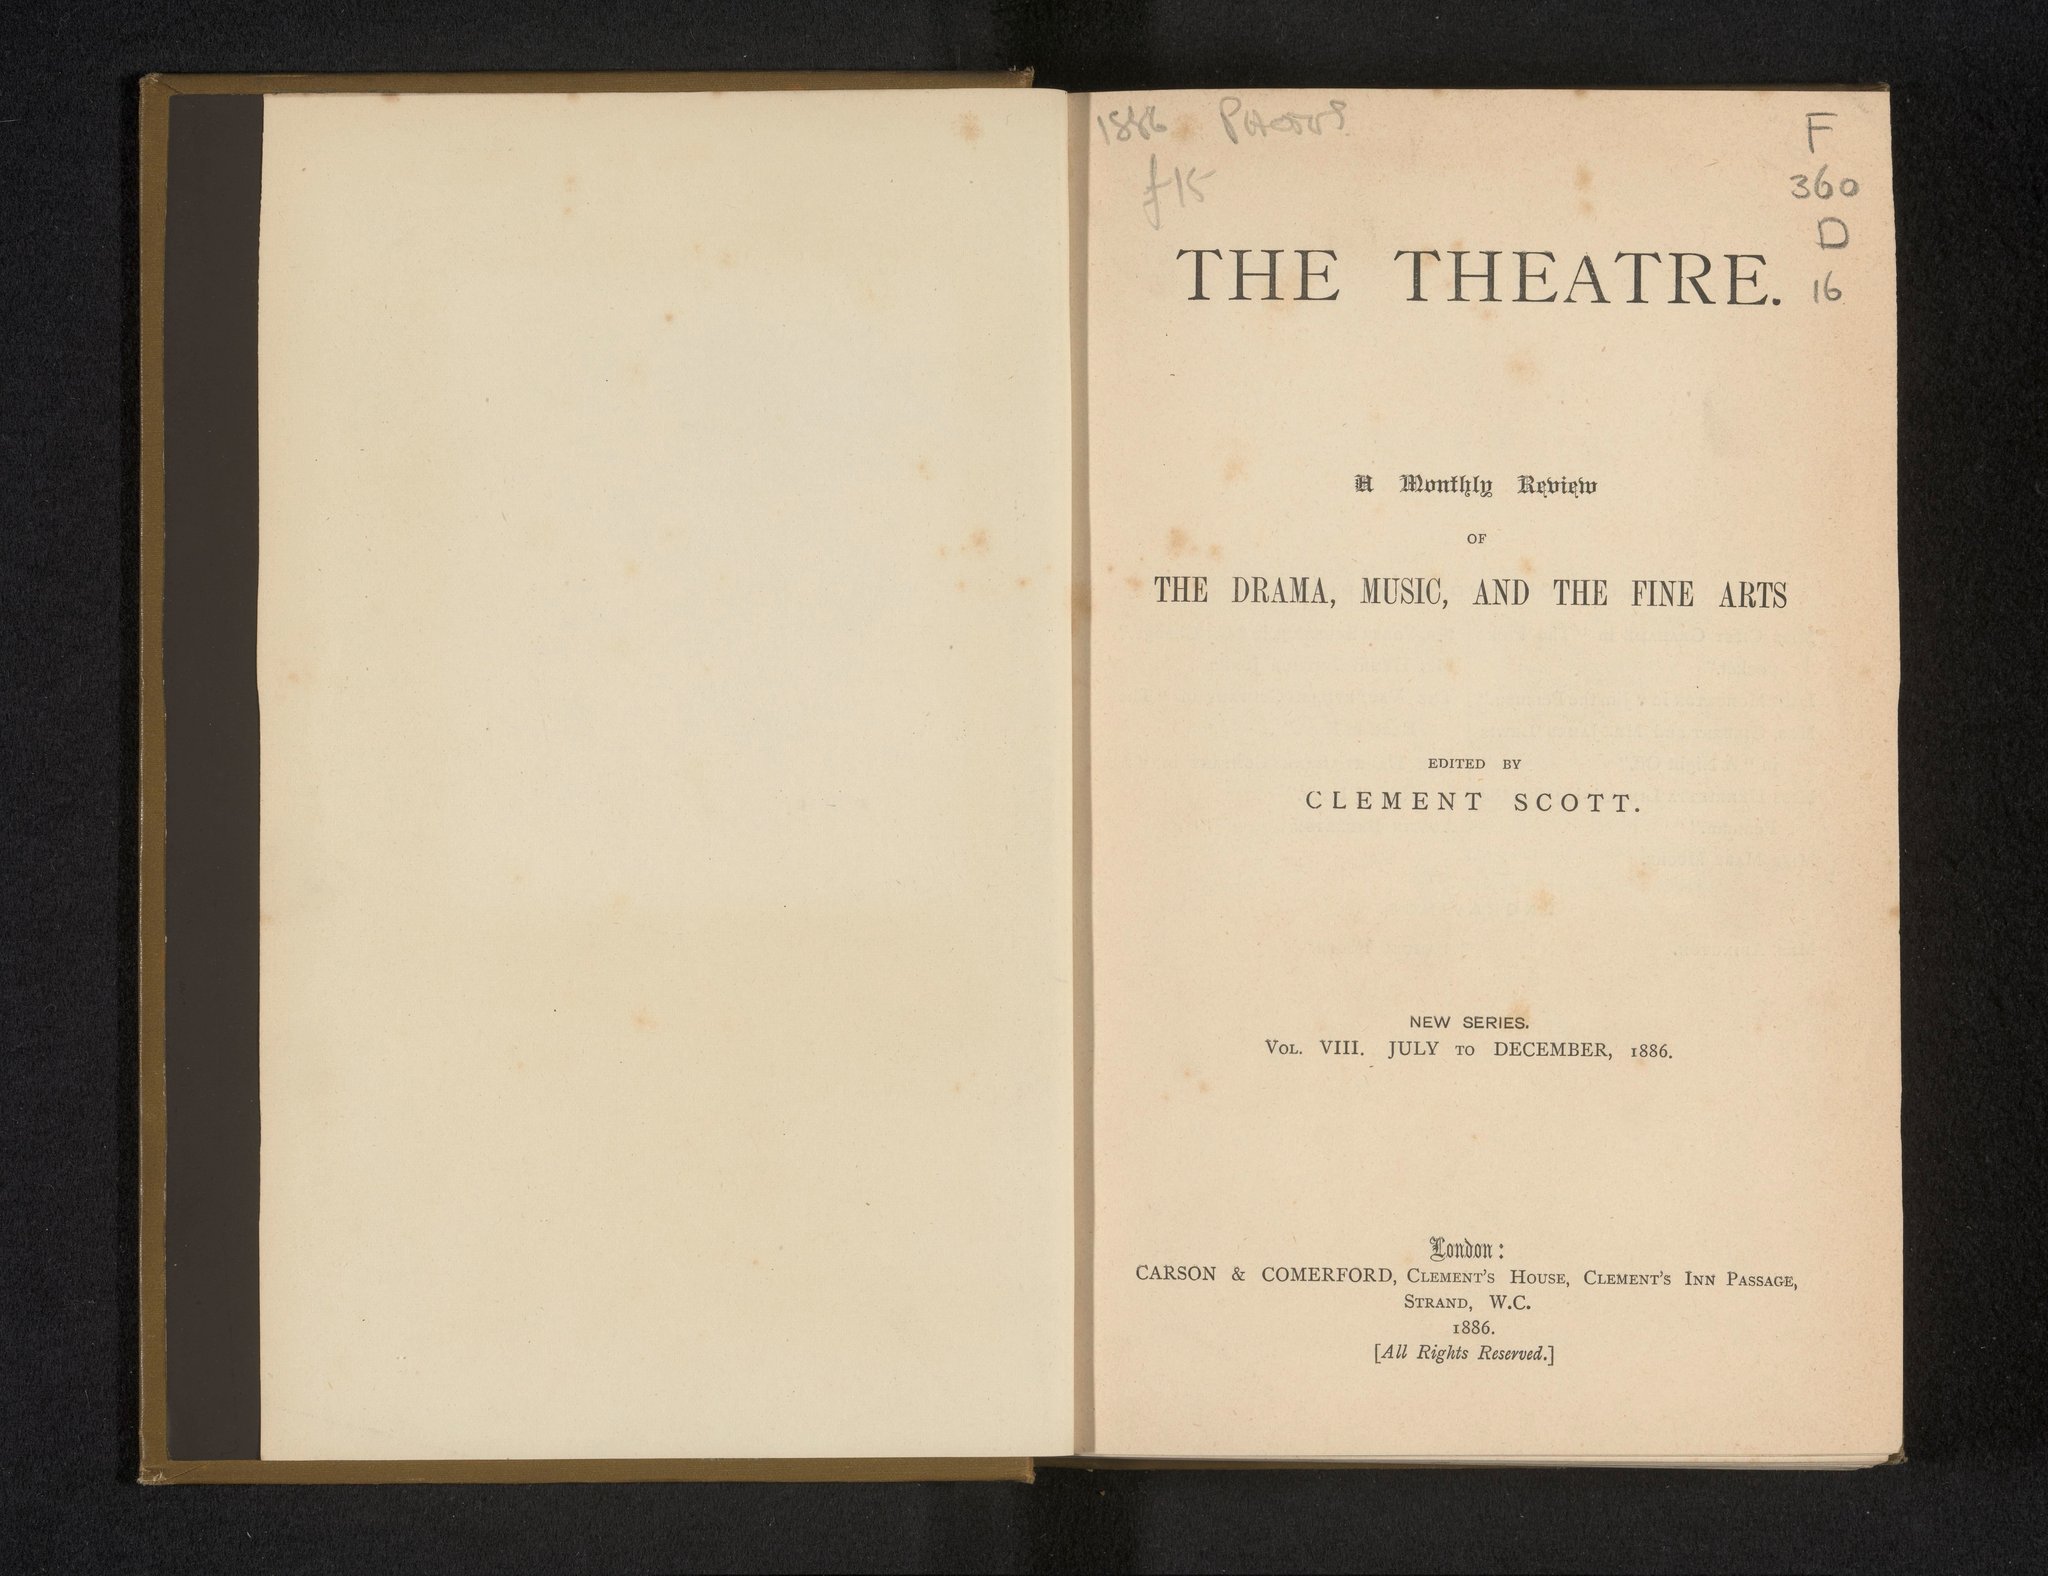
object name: magazine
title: The theatre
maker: clement scott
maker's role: redacteur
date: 1886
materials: leather, paper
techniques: printing, woodburytype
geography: london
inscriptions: annotation: ‘MAR 1995’